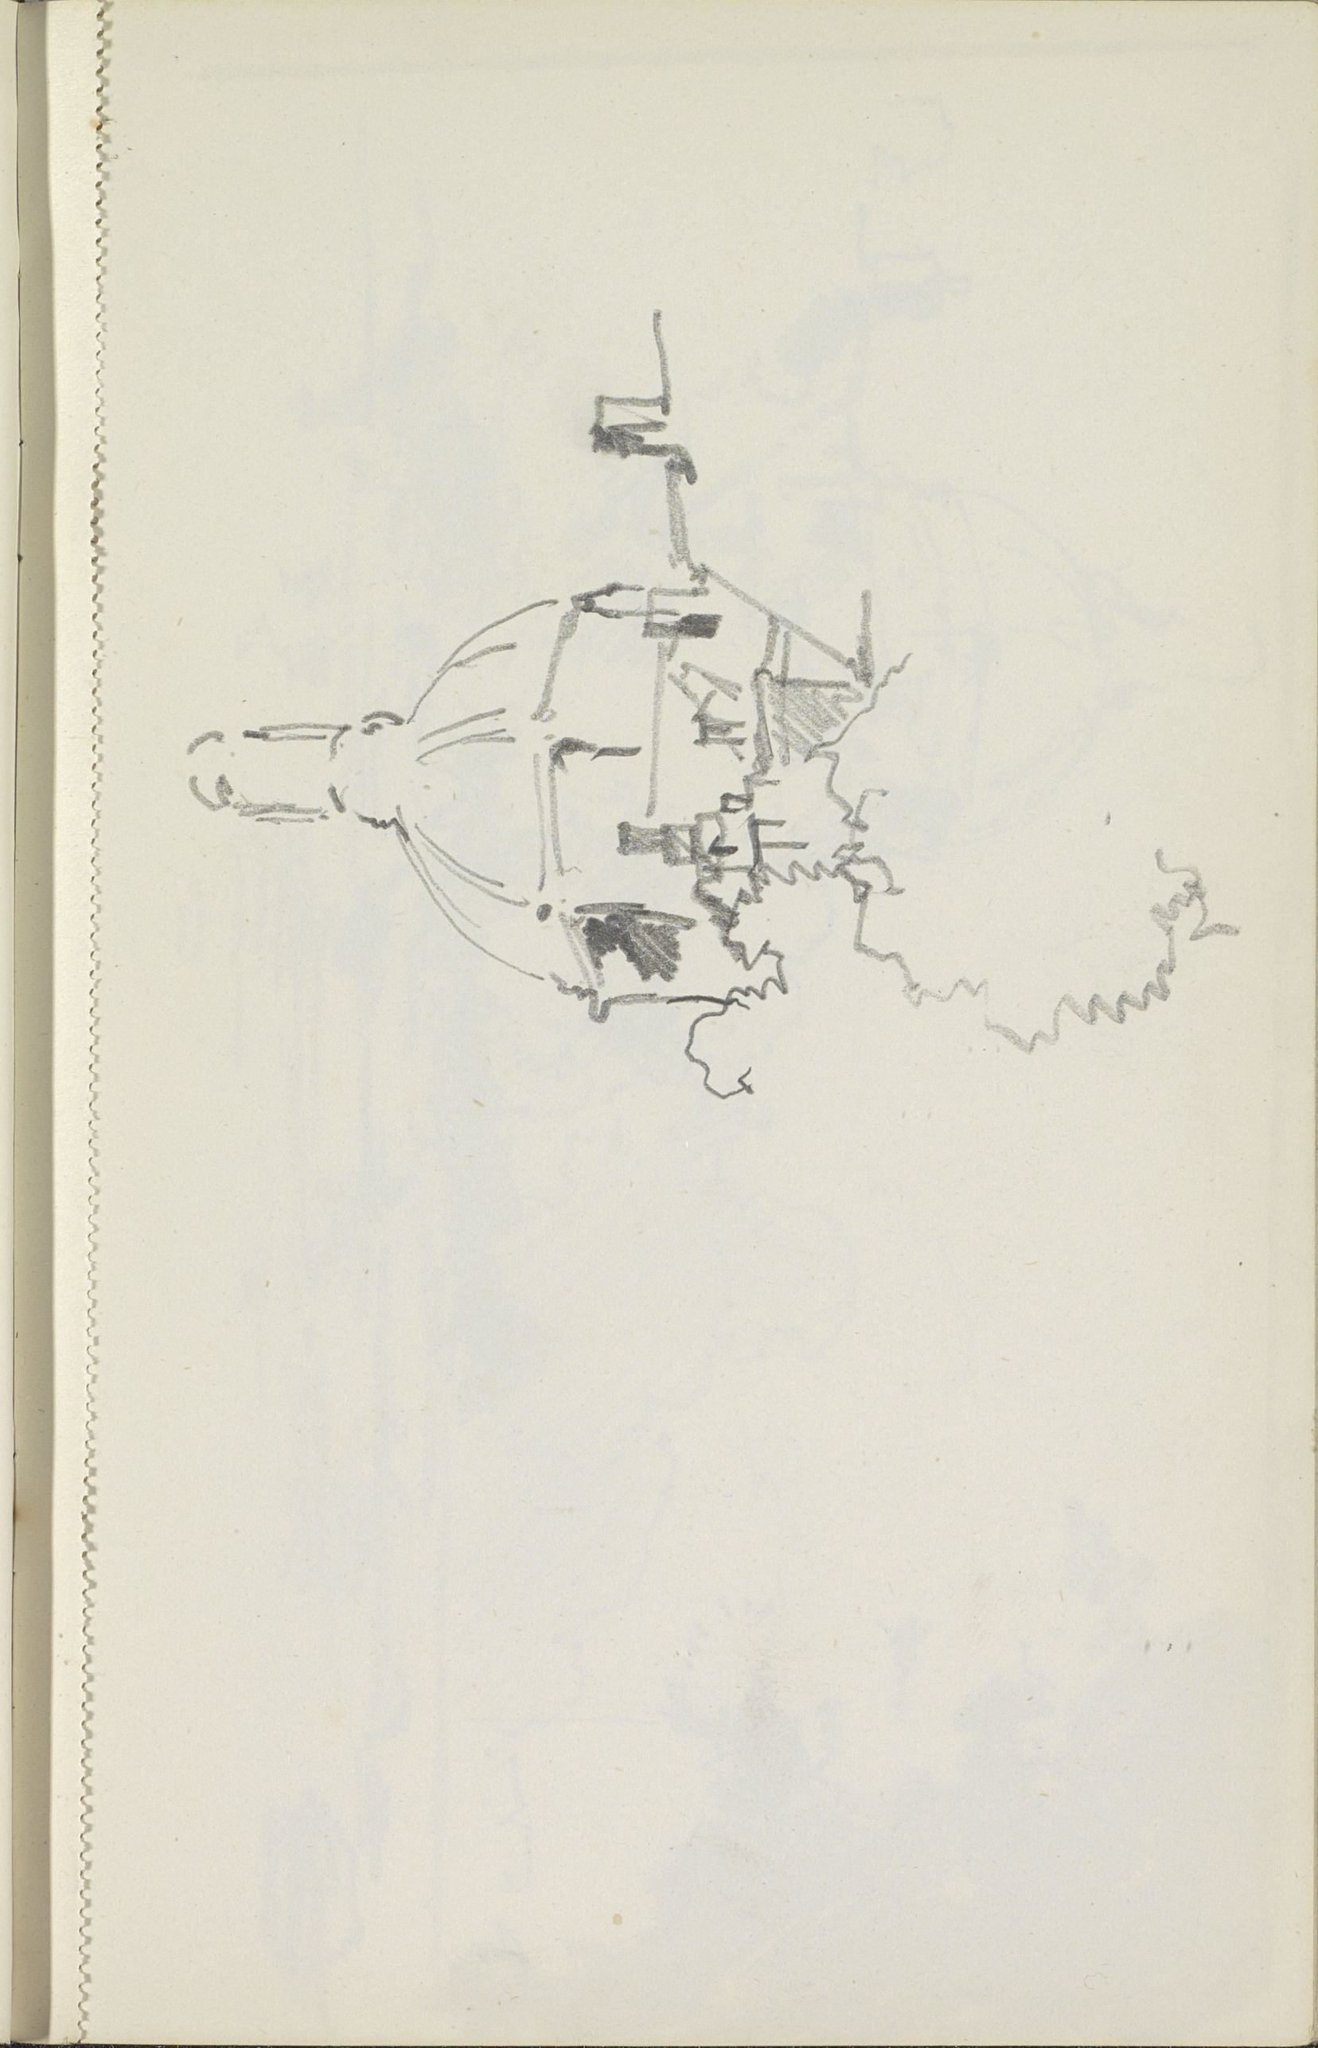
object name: sketchbook leaf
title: Ronde Lutherse Kerk te Amsterdam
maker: cornelis vreedenburgh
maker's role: draughtsman, print maker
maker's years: 1880-1946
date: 1890-1946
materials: paper, pencil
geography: amsterdam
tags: church (exterior)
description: Blad 41 recto uit een schetsboek met 50 bladen.